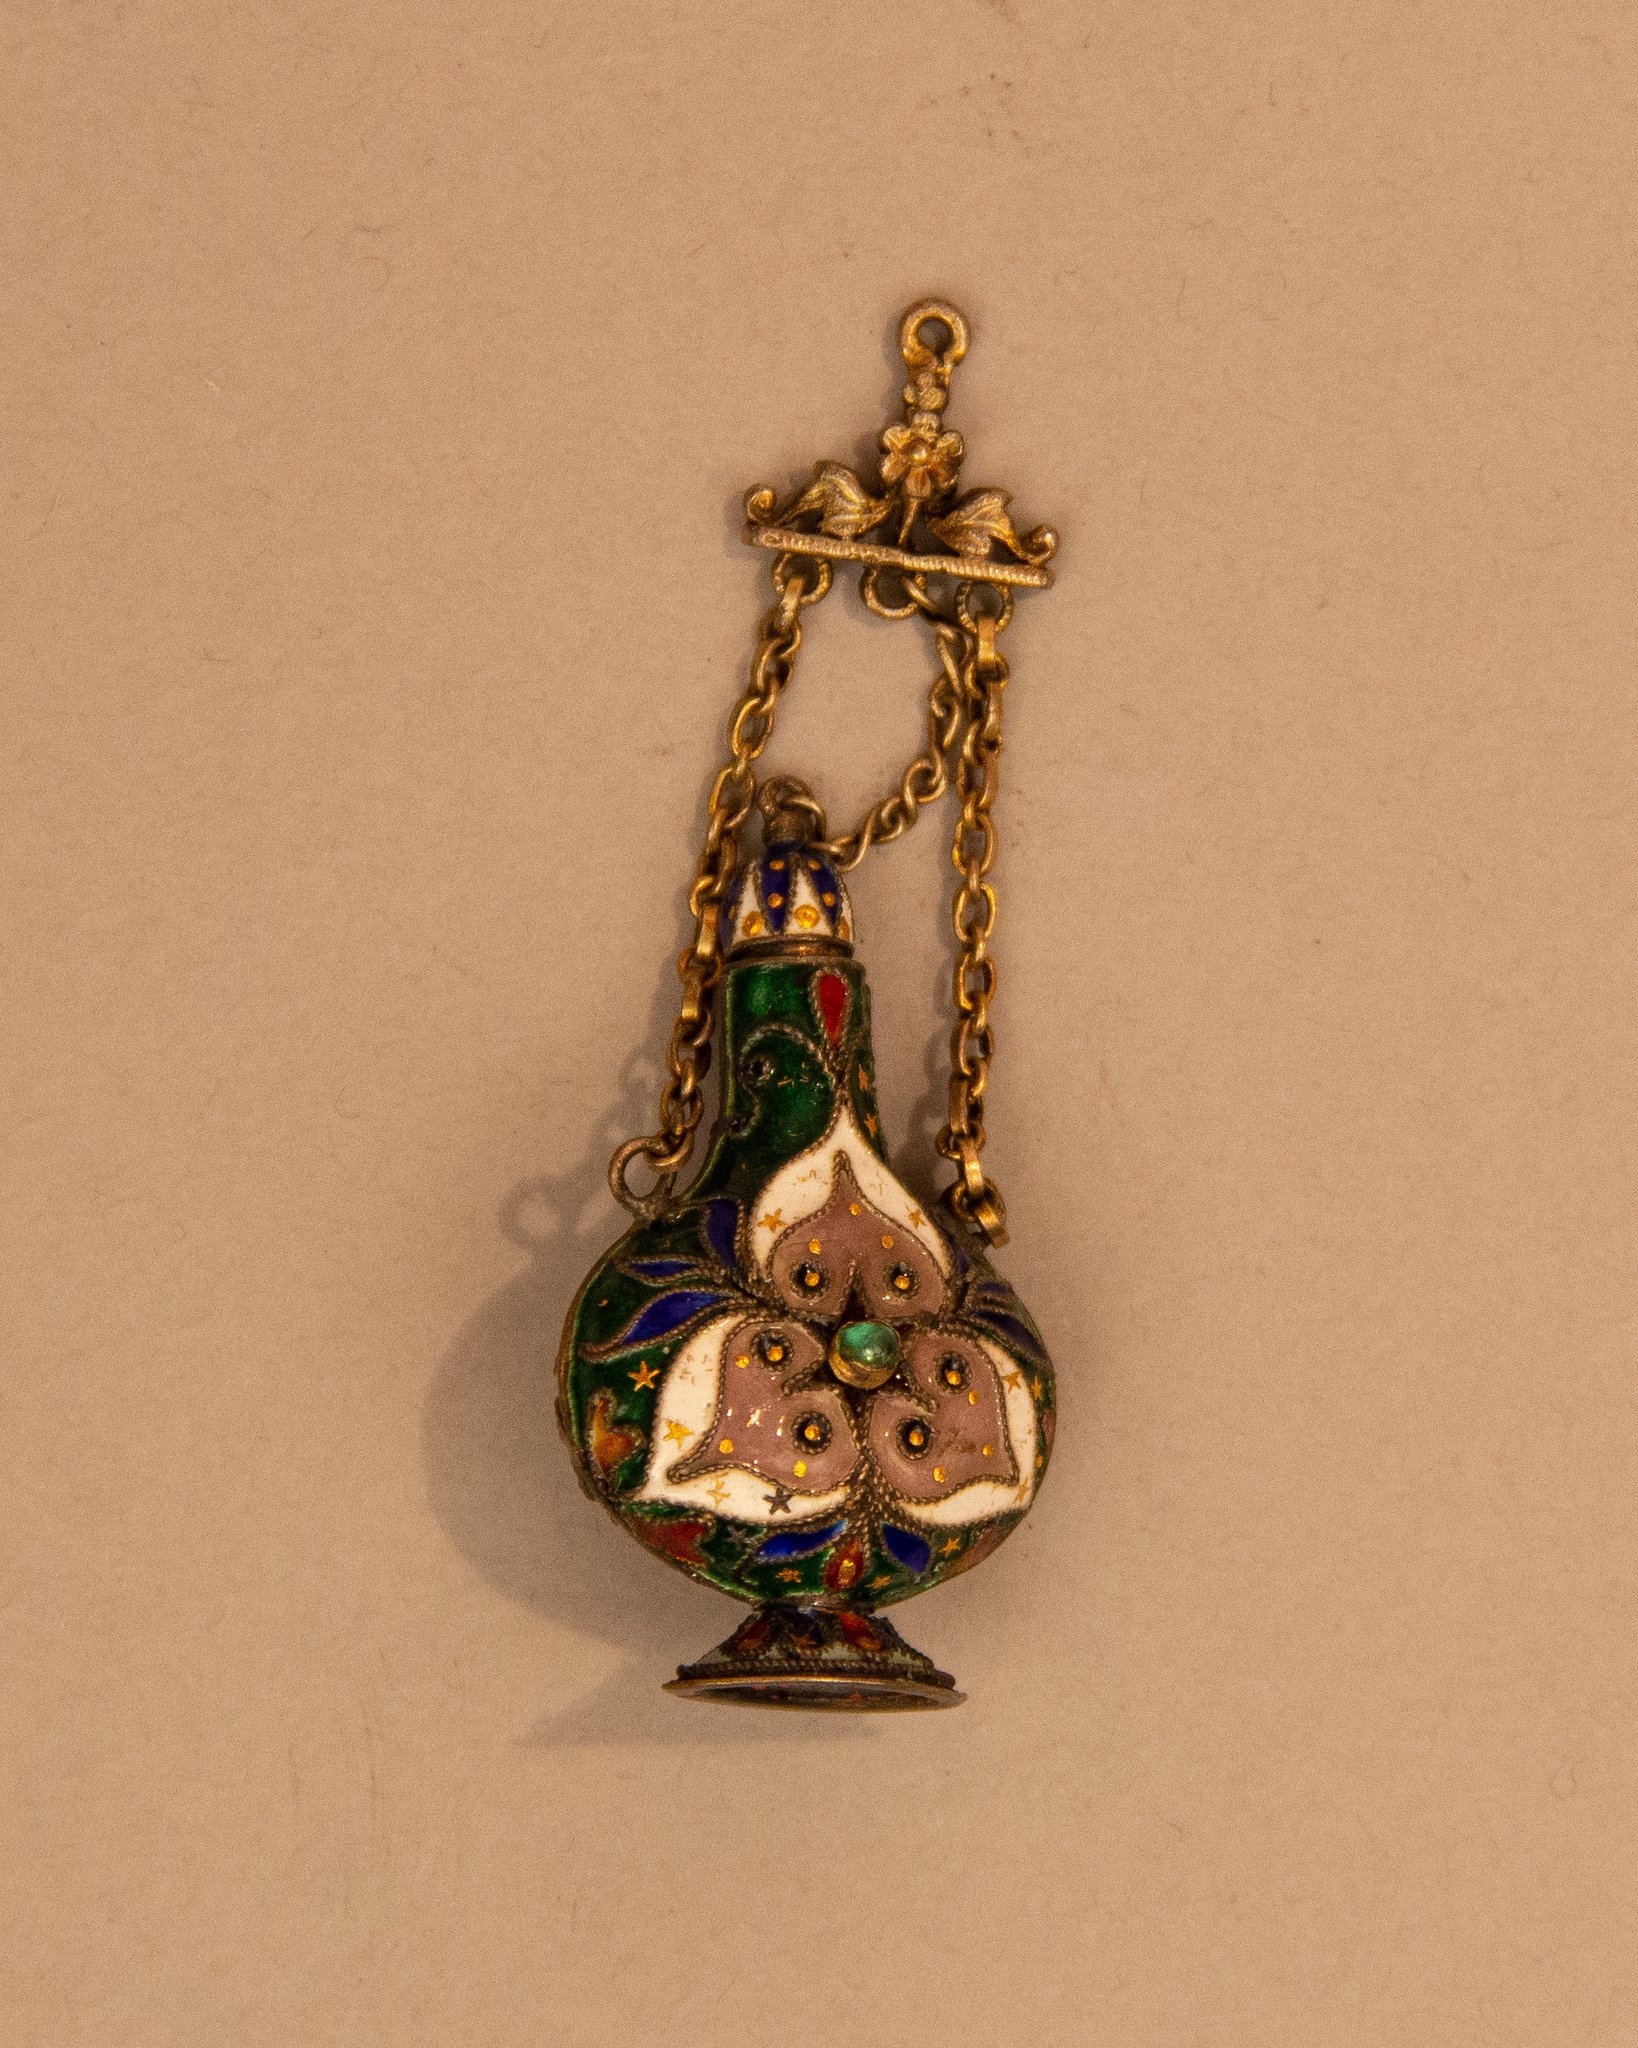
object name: flask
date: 1701-1900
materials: gold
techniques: enamel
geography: india